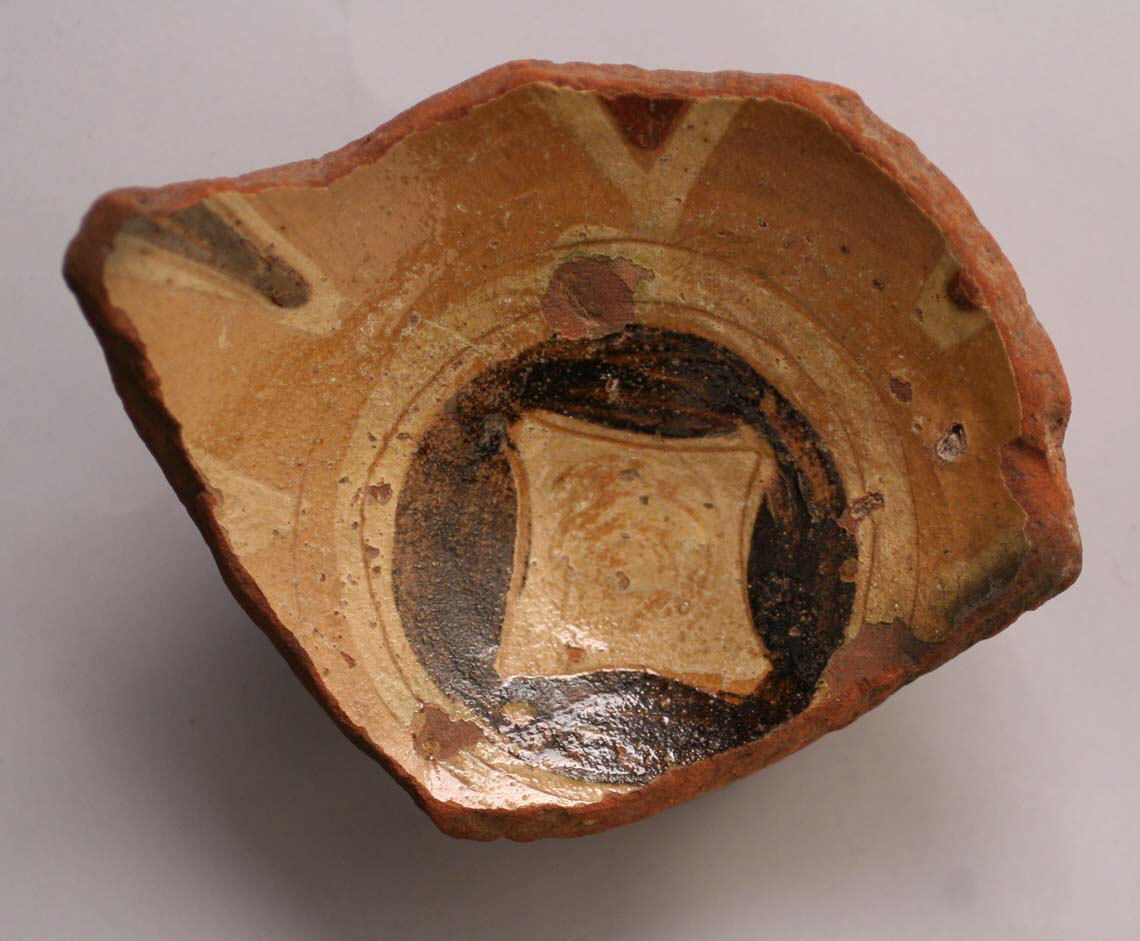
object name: ceramic fragment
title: Fragment of a Bowl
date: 1301-1500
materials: earthenware, glaze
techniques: coloring, incising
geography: egypt